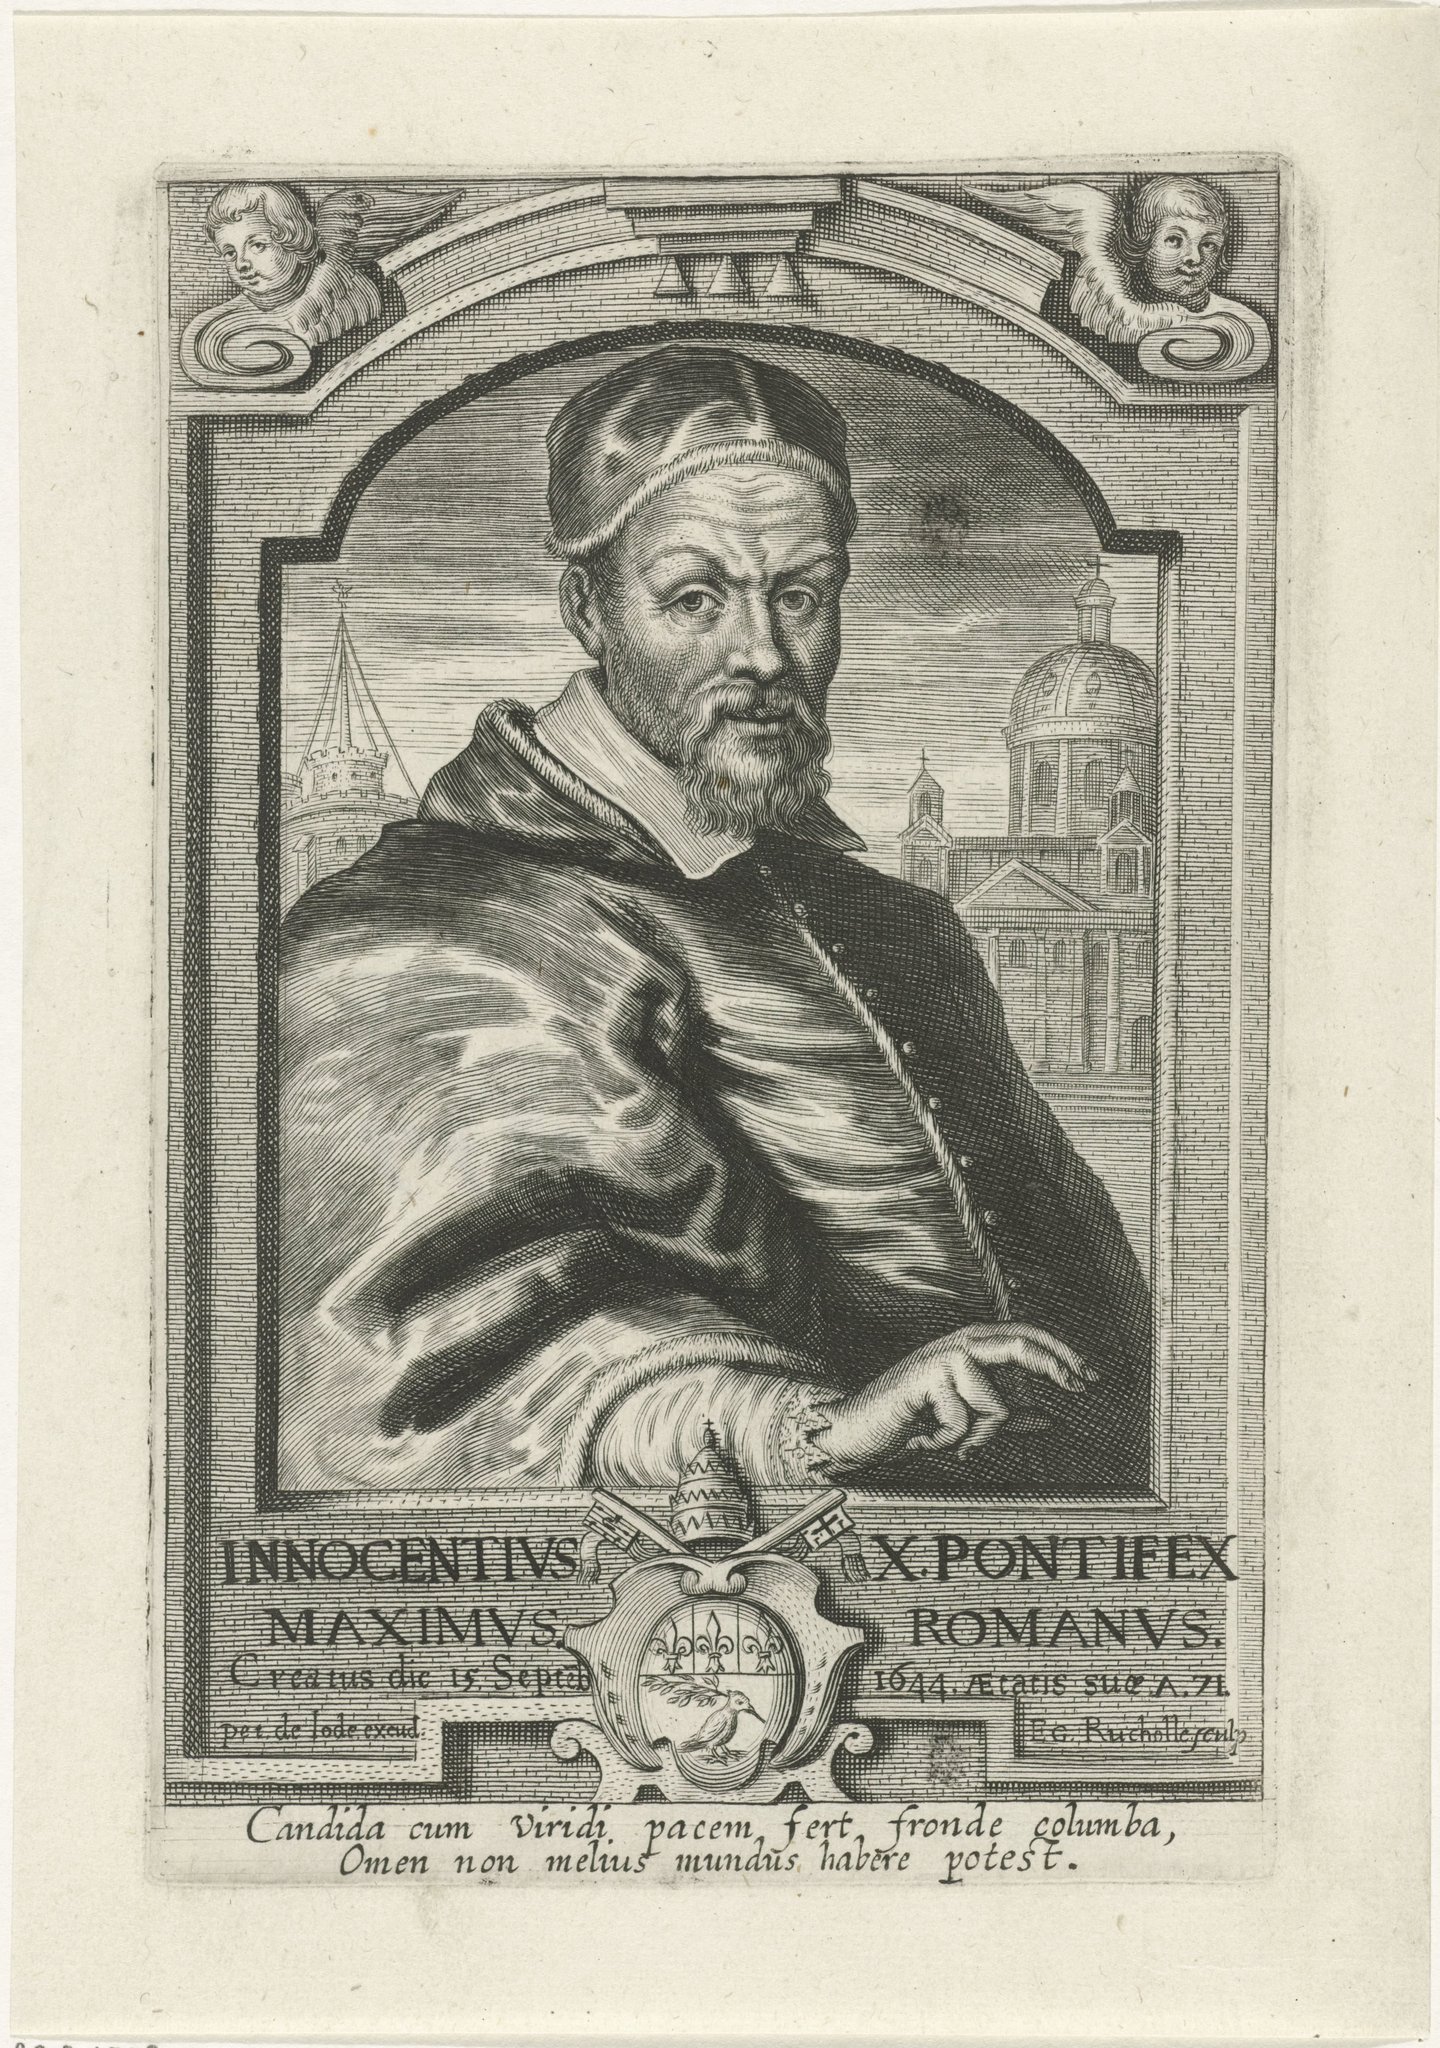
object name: print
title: Portret van paus Innocentius X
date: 1644-1662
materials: paper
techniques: engraving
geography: antwerp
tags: rome, innocentius x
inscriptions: collector's mark: Lugt 2228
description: Portret van paus Innocentius X op 71-jarige leeftijd. In de omlijsting zijn pauselijke wapen.